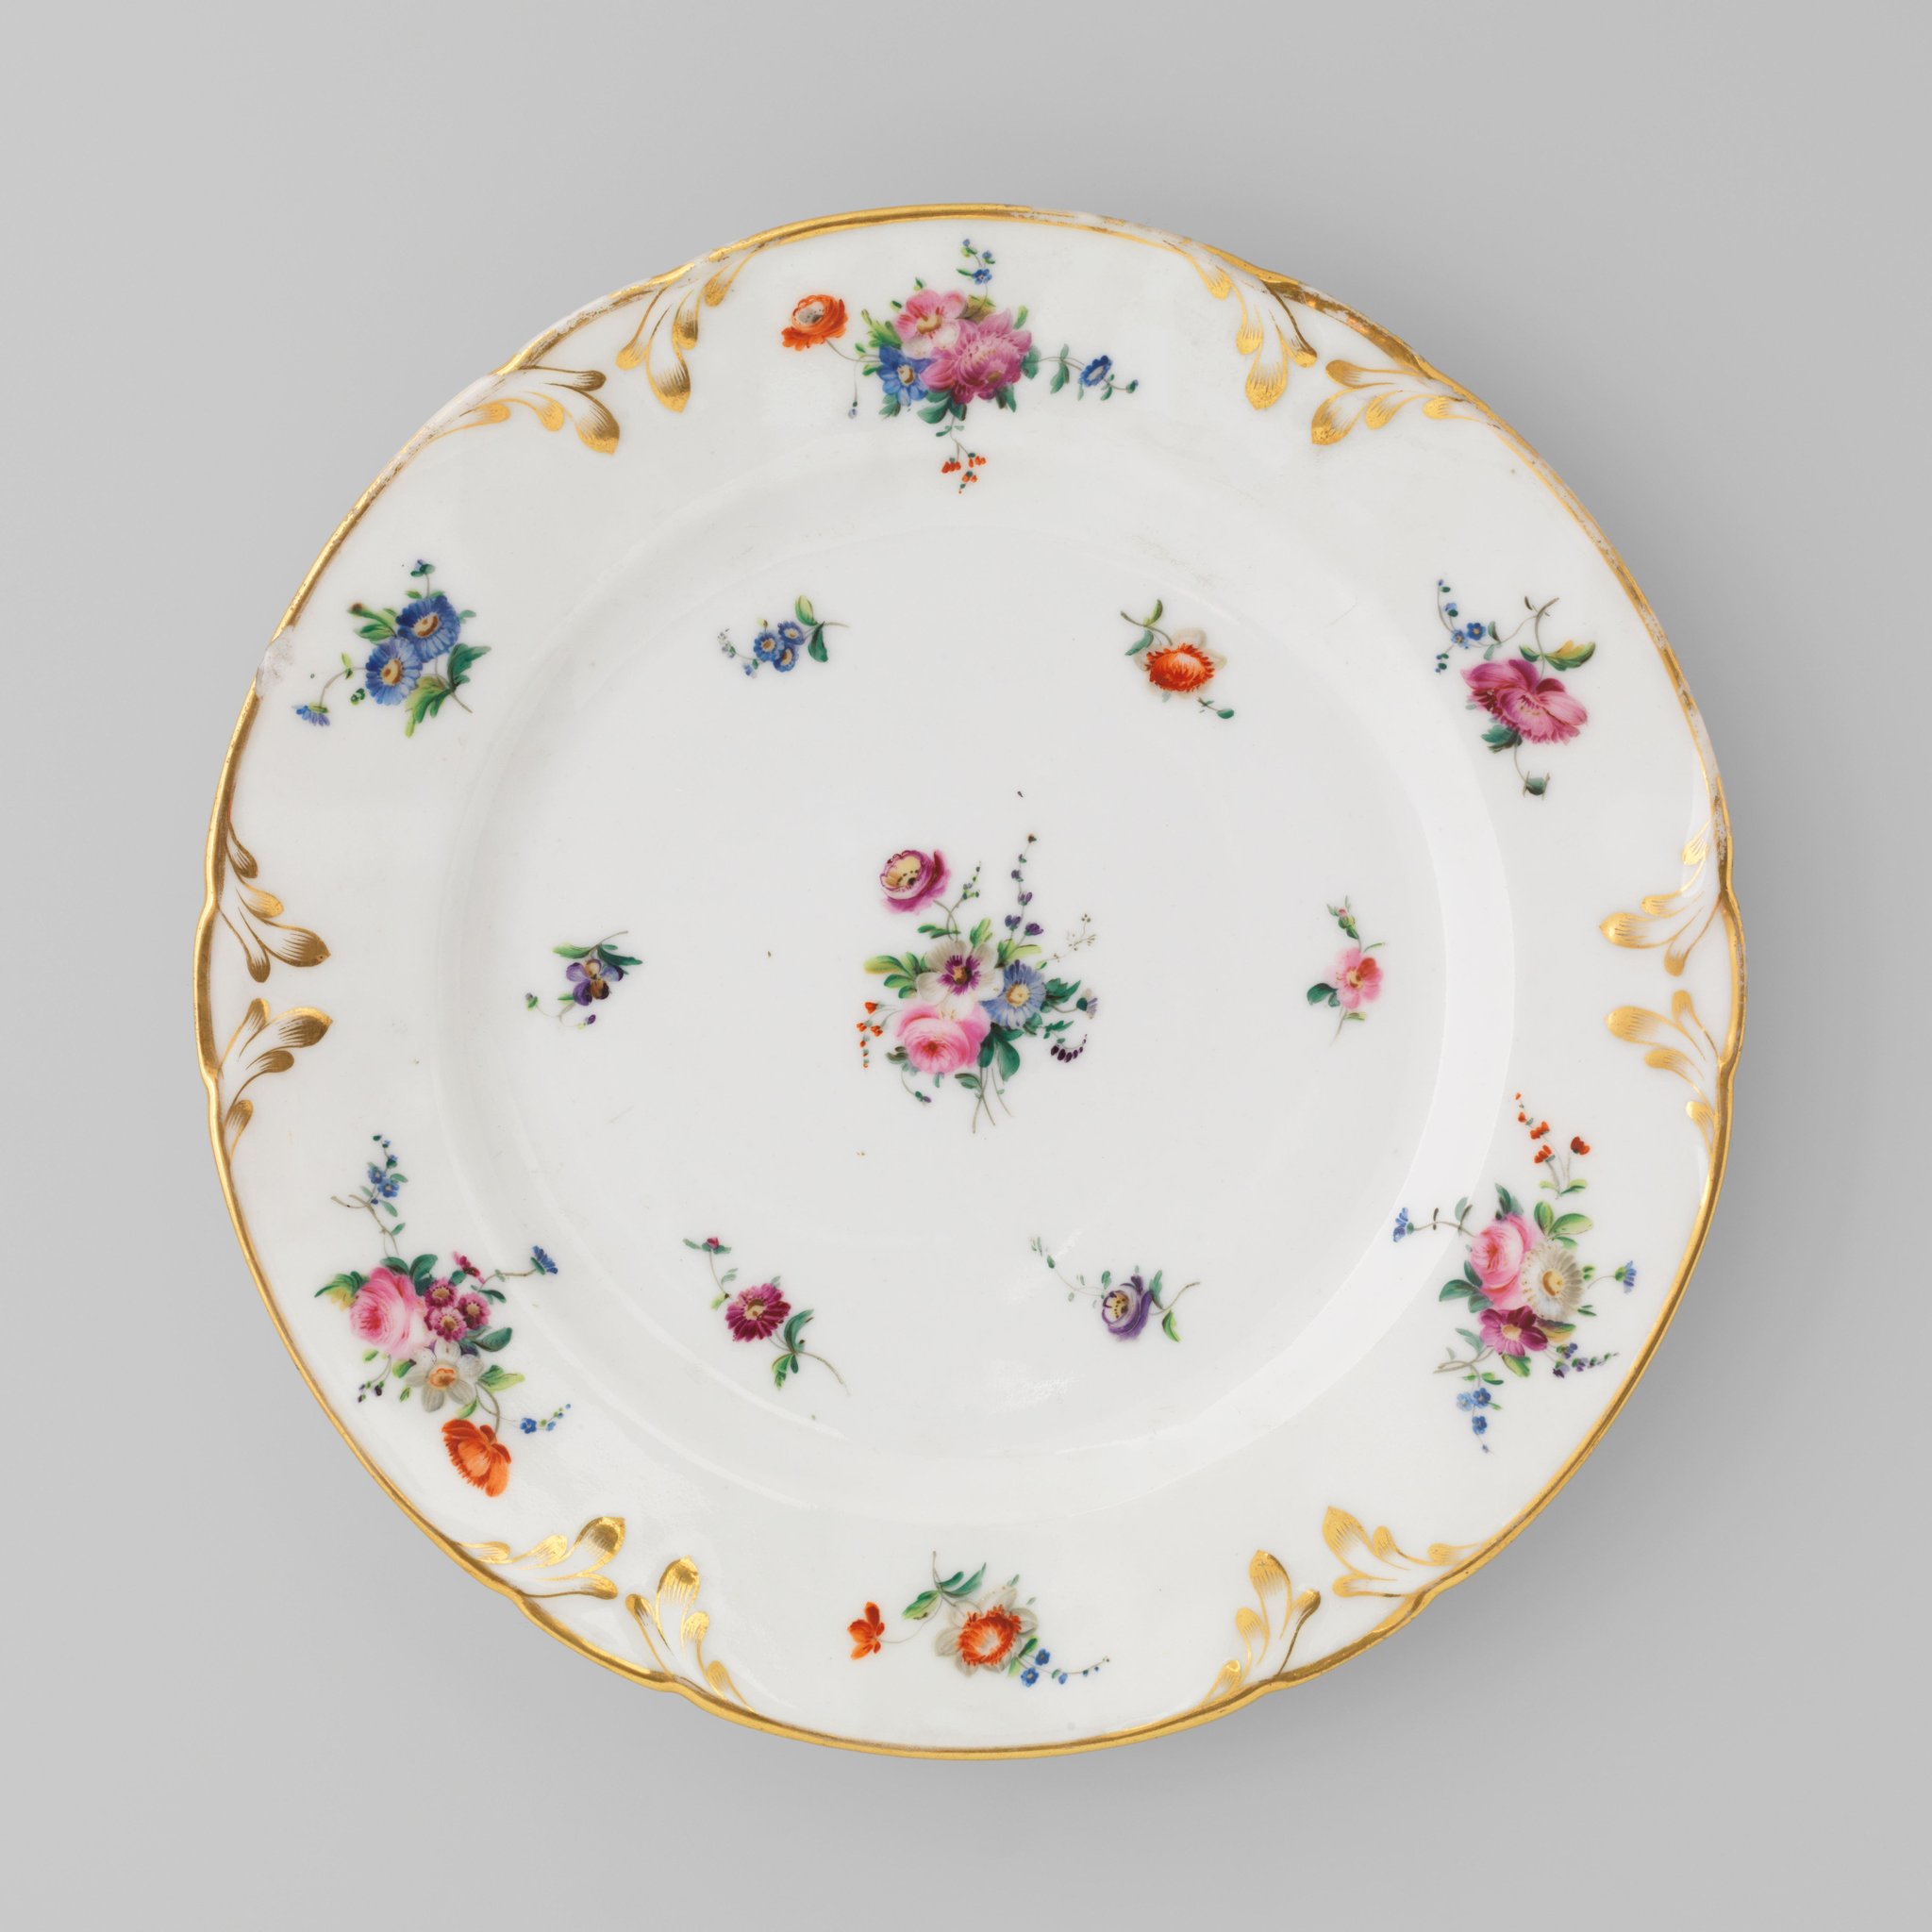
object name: plate dish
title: Plate with bouquets and flower sprays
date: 1839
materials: glaze, gold, paint, porcelain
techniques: firing, forming, gilding, turning, vitrification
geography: paris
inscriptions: mark: ‘DENUELLE/ Boulevard St. Denis 18/ à Paris’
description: Bord (dessertbord) van porselein met een gelobde rand, beschilderd op het glazuur in blauw, rood, roze, groen, geel, paars, zwart en goud. Op het plat boeketten van verschillende bloemen en strooibloemen. Vanuit de gelobde, gouden rand, gemodelleerde bladranken in reliëf, aangezet met goud. Hiertussen boeketten. Drie proenen op de onderzijde. Gemerkt op de onderzijde met 'DENUELLE/ Boulevard St. Denis 18/ à Paris'.